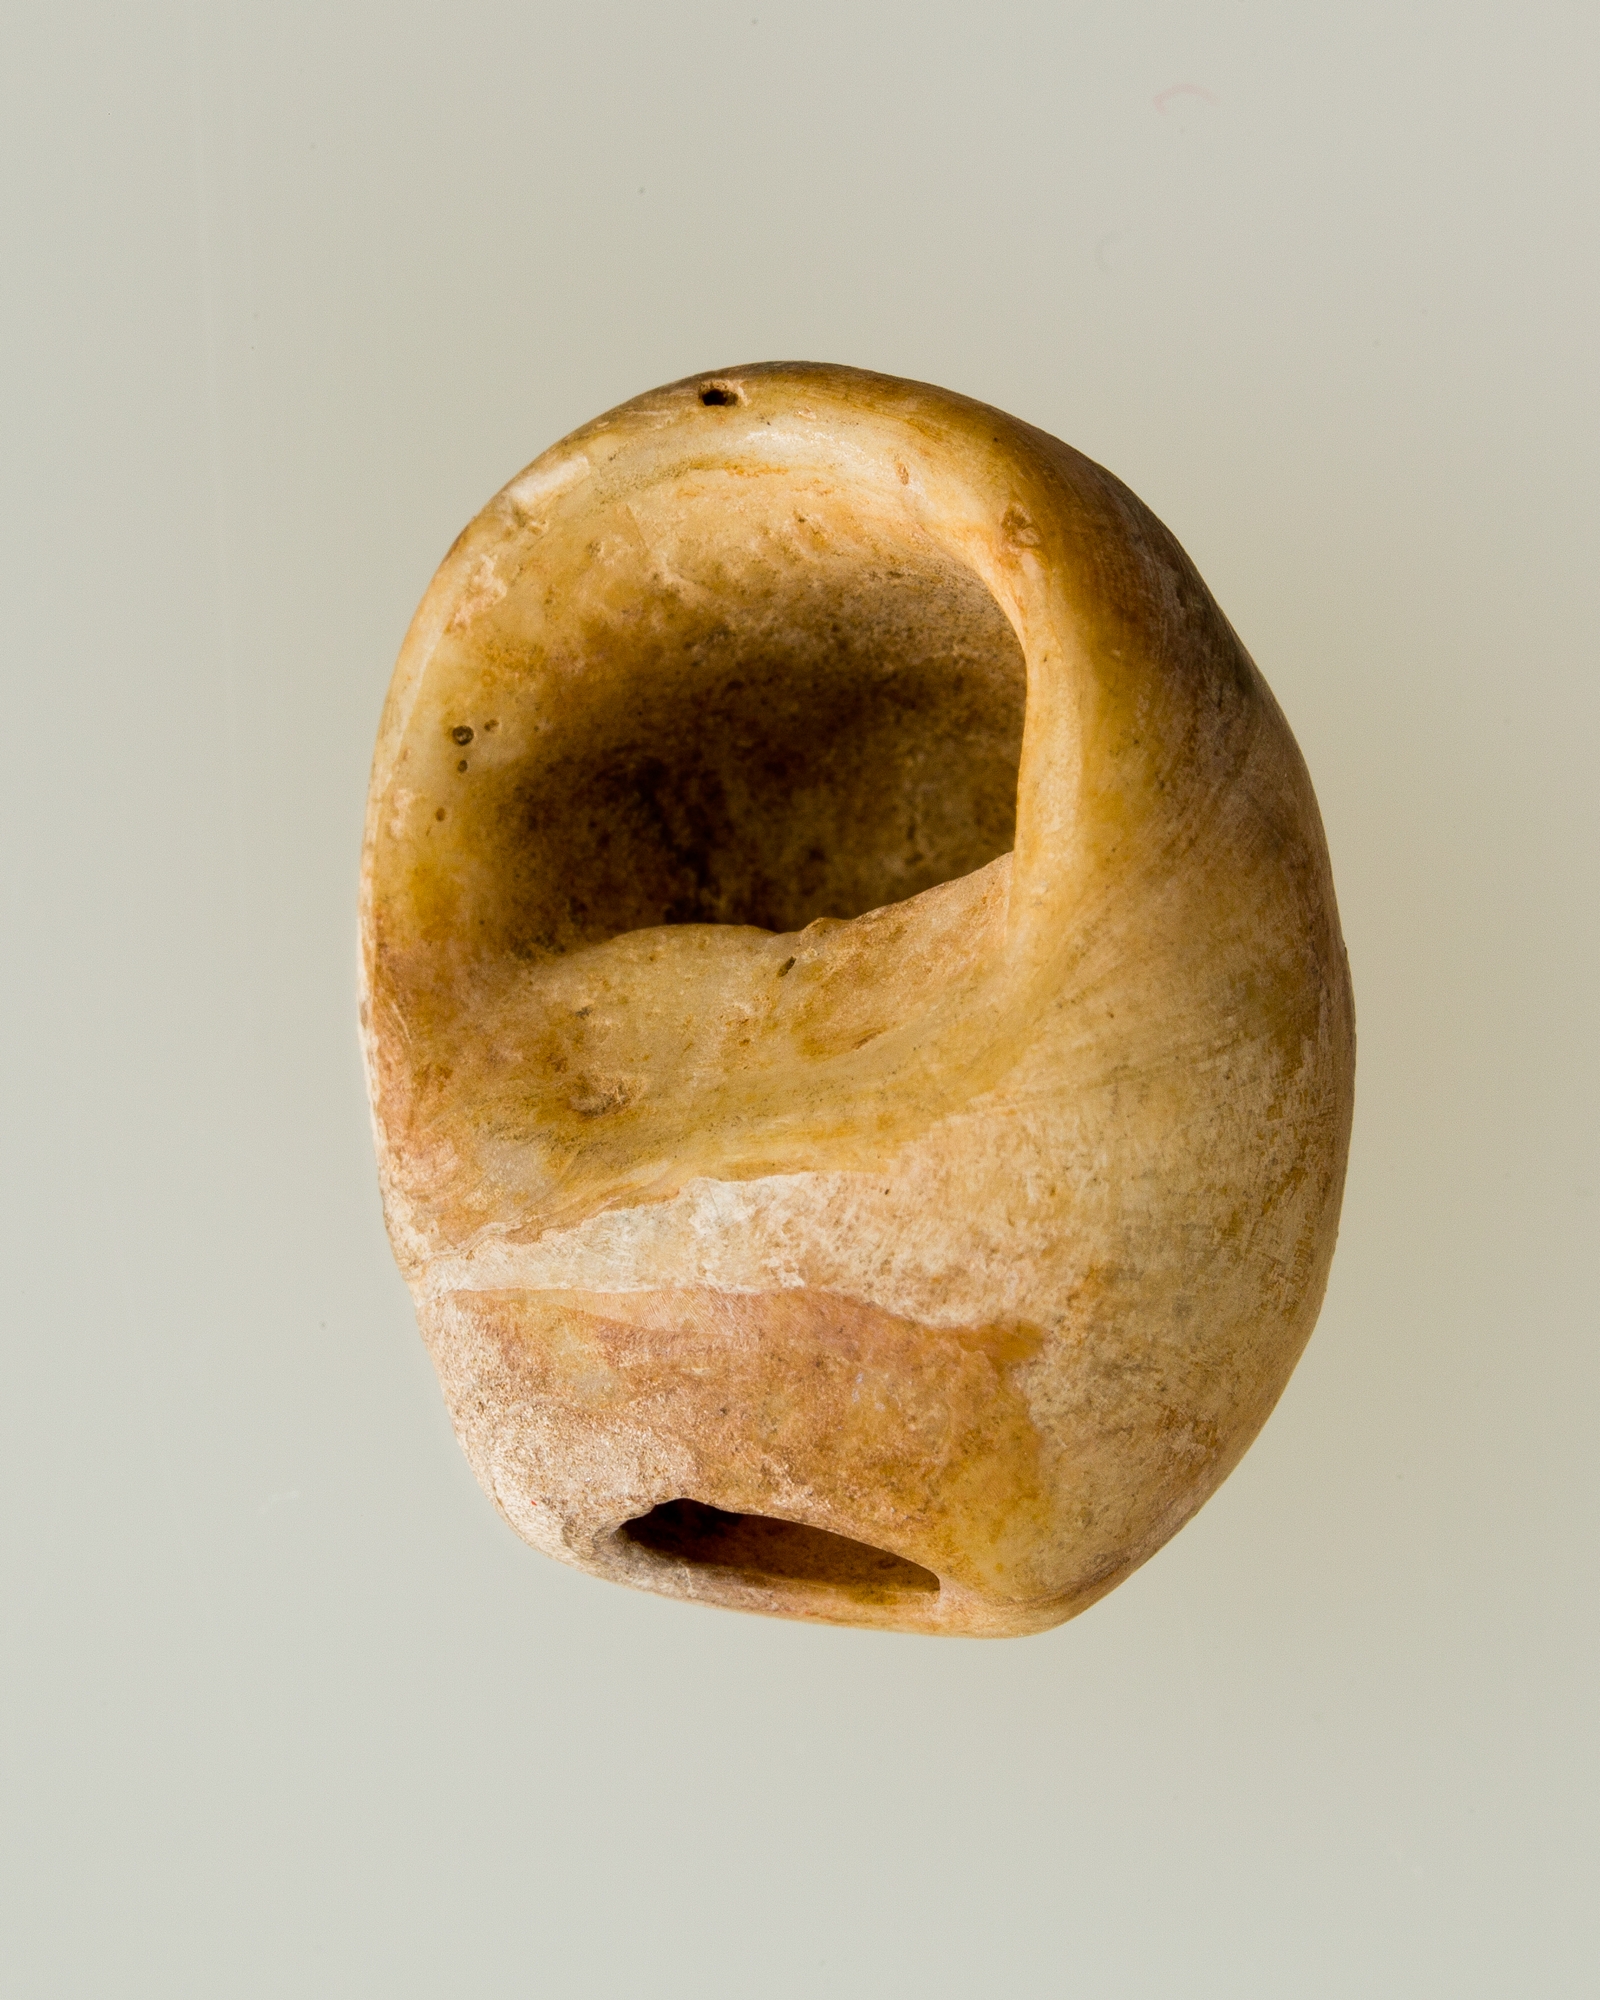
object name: pendant, shell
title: Shell pendant or bead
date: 3850-2960 BCE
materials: shell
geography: egypt